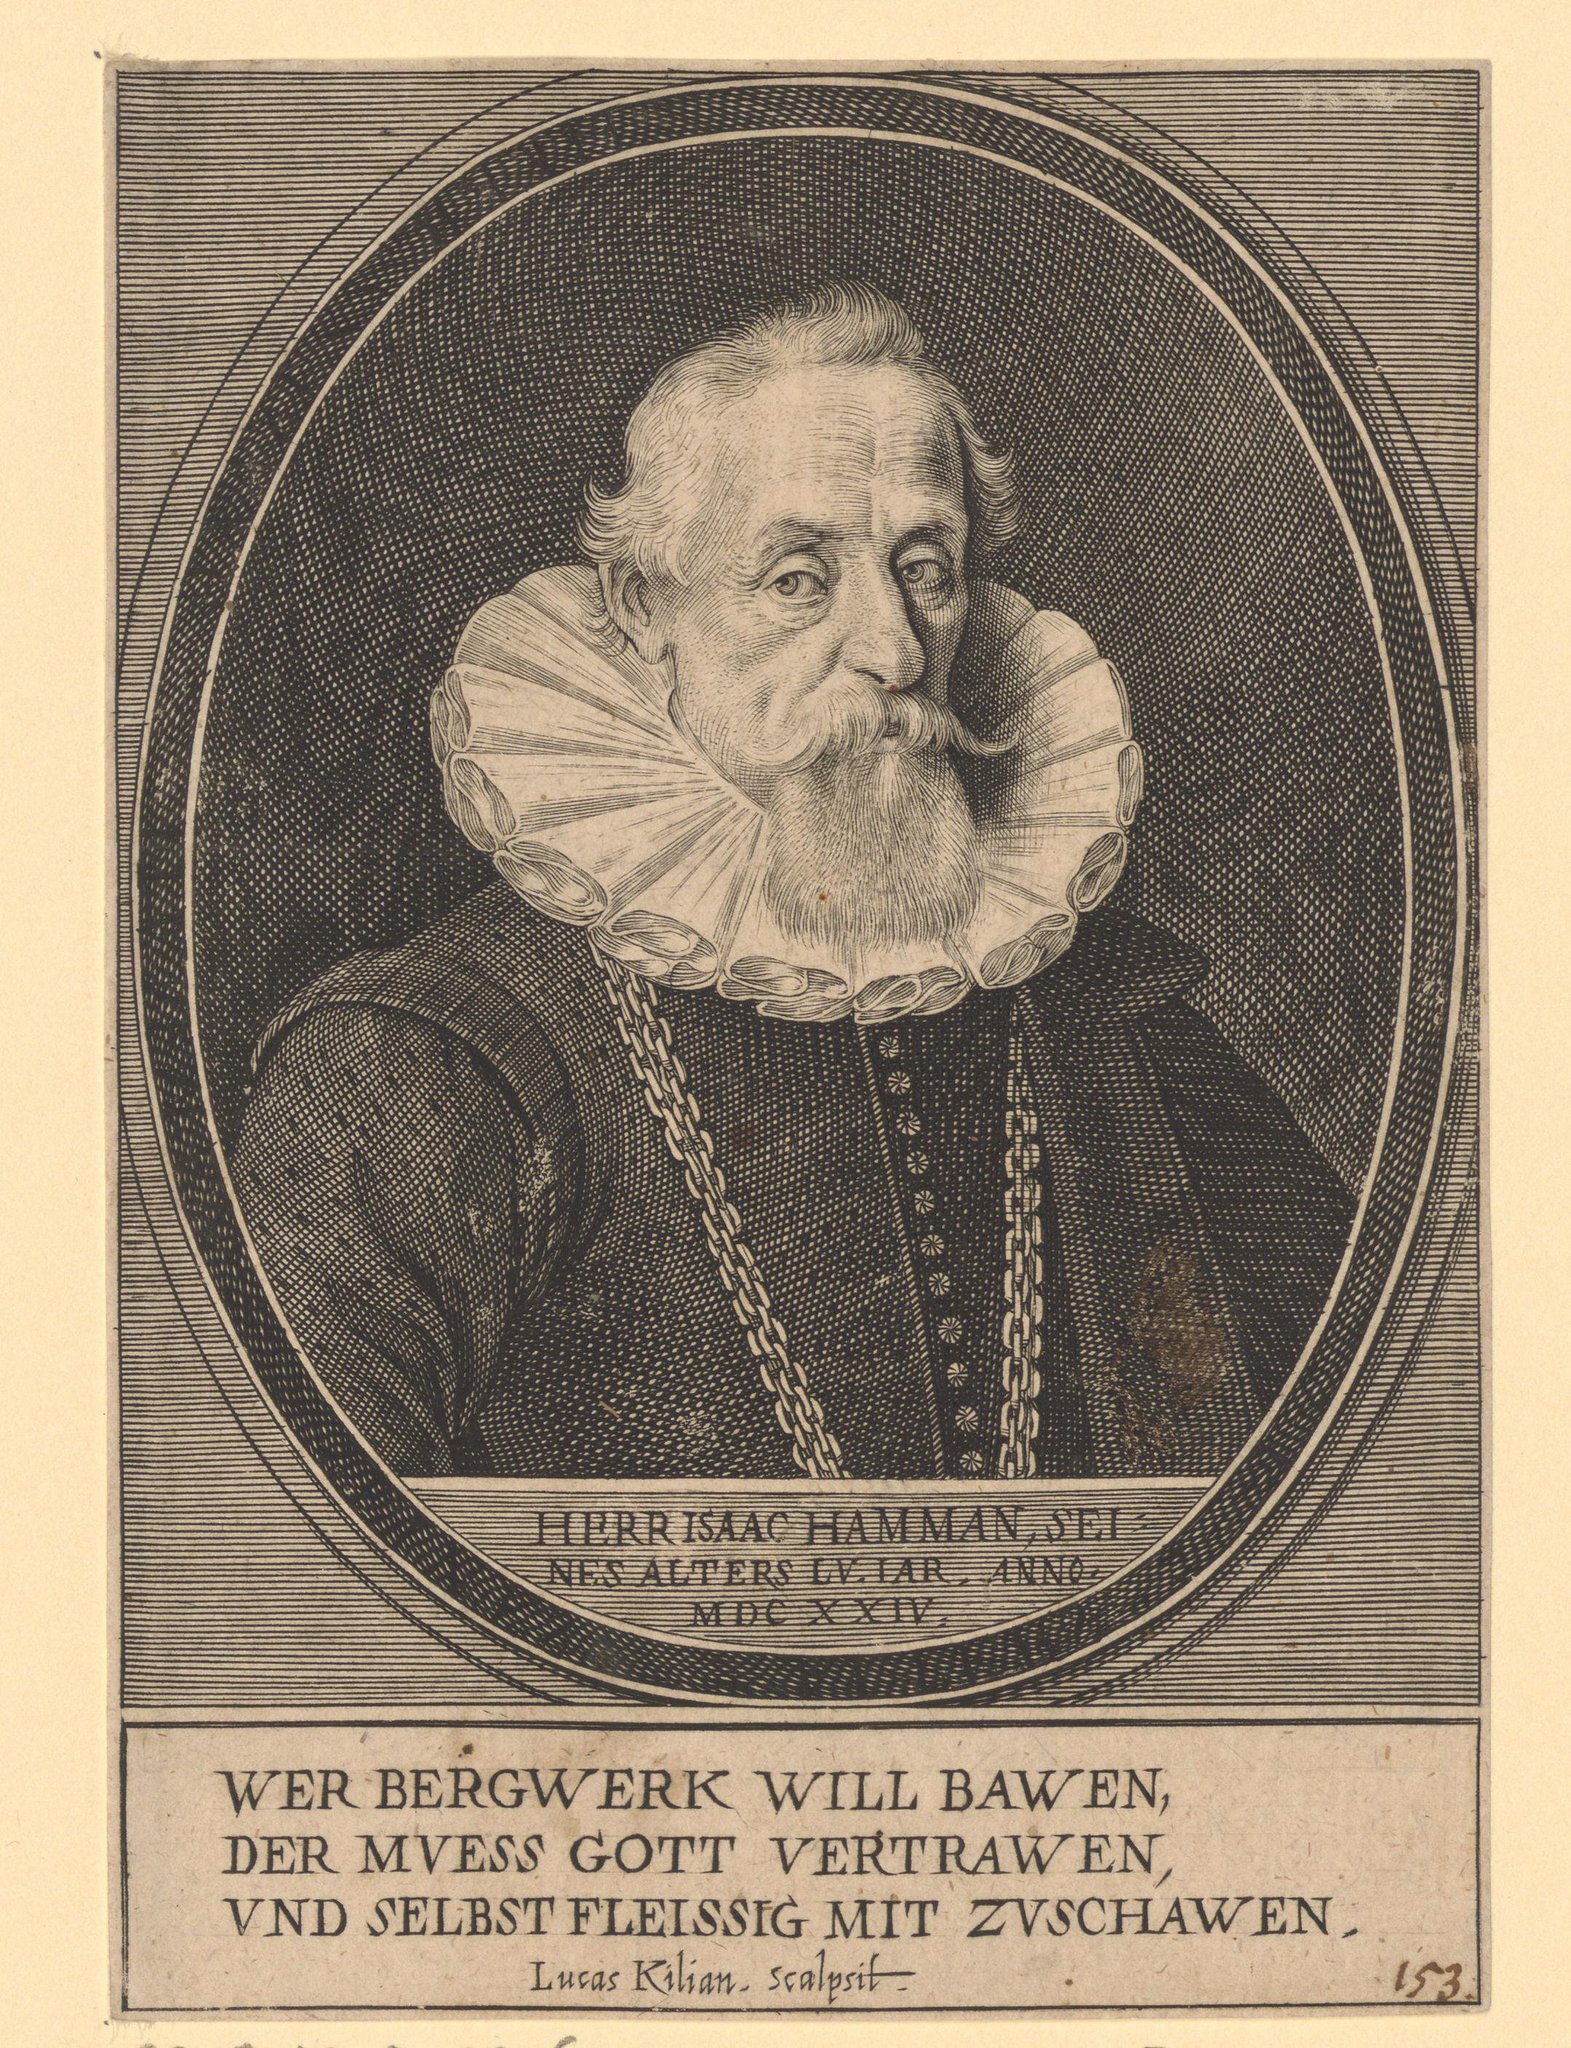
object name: print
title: Portret van Isaac Hamman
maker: lucas kilian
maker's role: draughtsman, print maker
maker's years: 1579-1637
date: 1624-1637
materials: paper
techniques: engraving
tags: historical persons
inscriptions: collector's mark: Lugt 2228